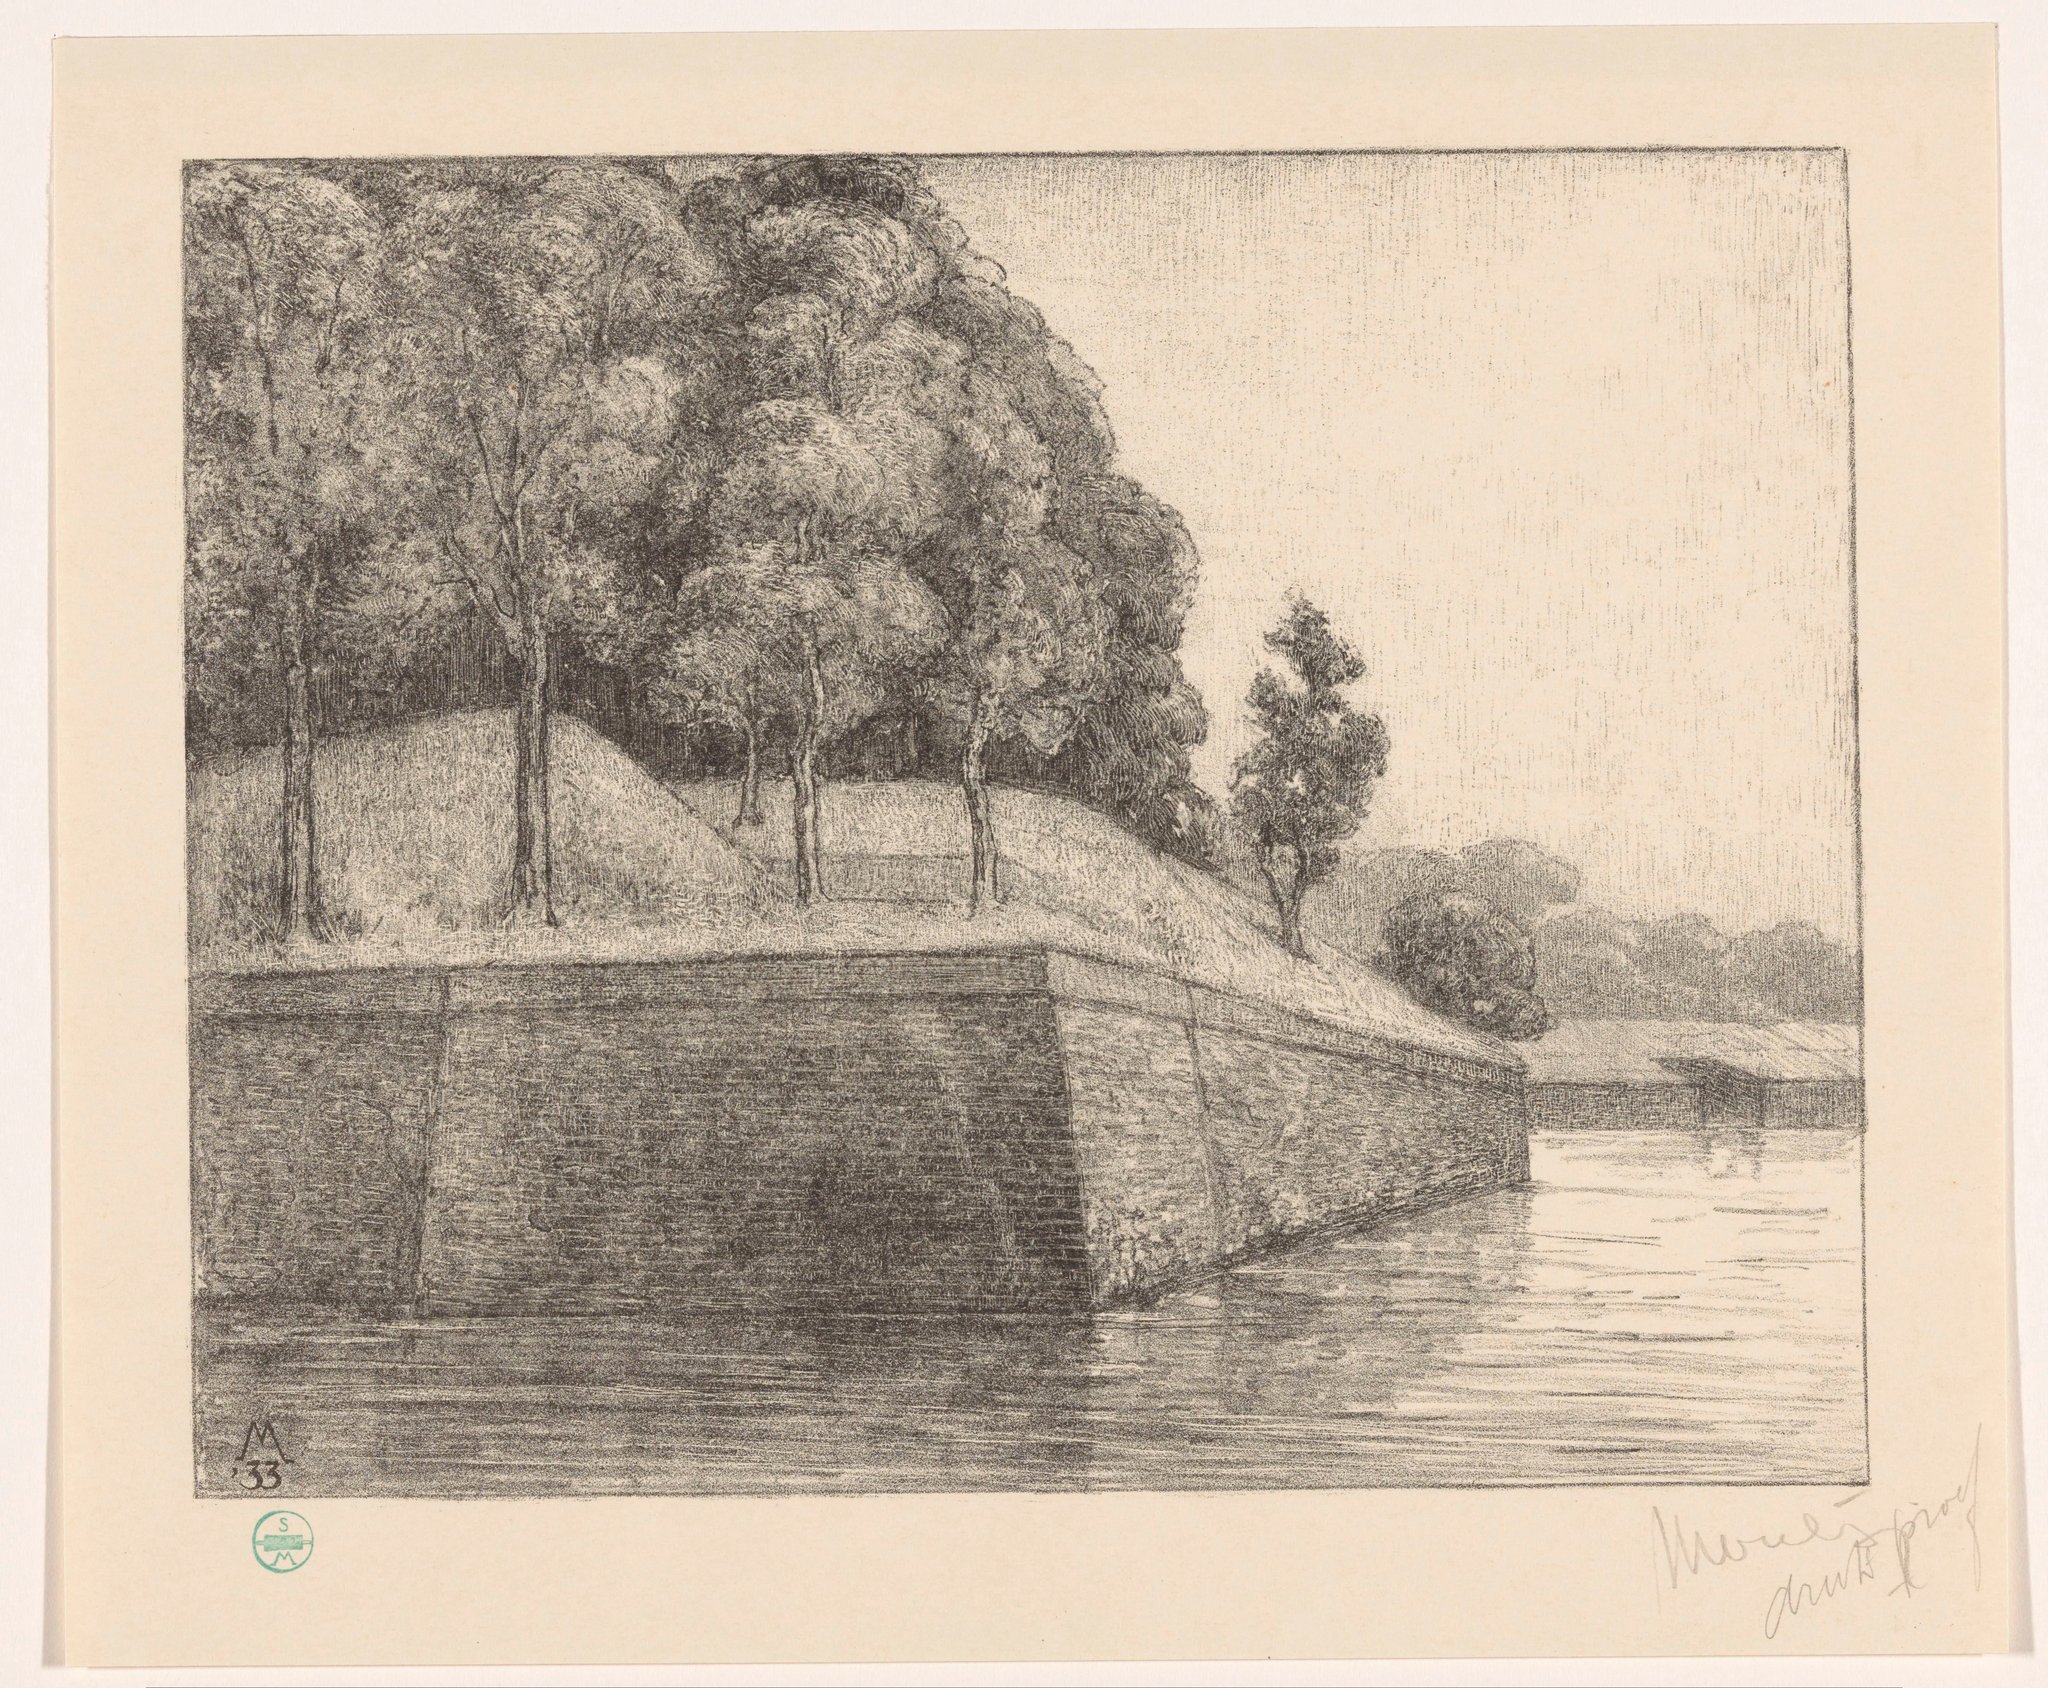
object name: print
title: De wallen van Naarden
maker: simon moulijn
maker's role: draughtsman, print maker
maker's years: 1866-1948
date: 1933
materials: paper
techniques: lithograph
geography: the hague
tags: defence of fortification or city, bastion, bulwark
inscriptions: collector's mark: Lugt 2228, stamp: Lugt 2362b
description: Prent gebruikt voor: Moulijn, Simon. De wallen van Naarden. 's-Gravenhage: Stichting Menno van Coehoorn, 1934.